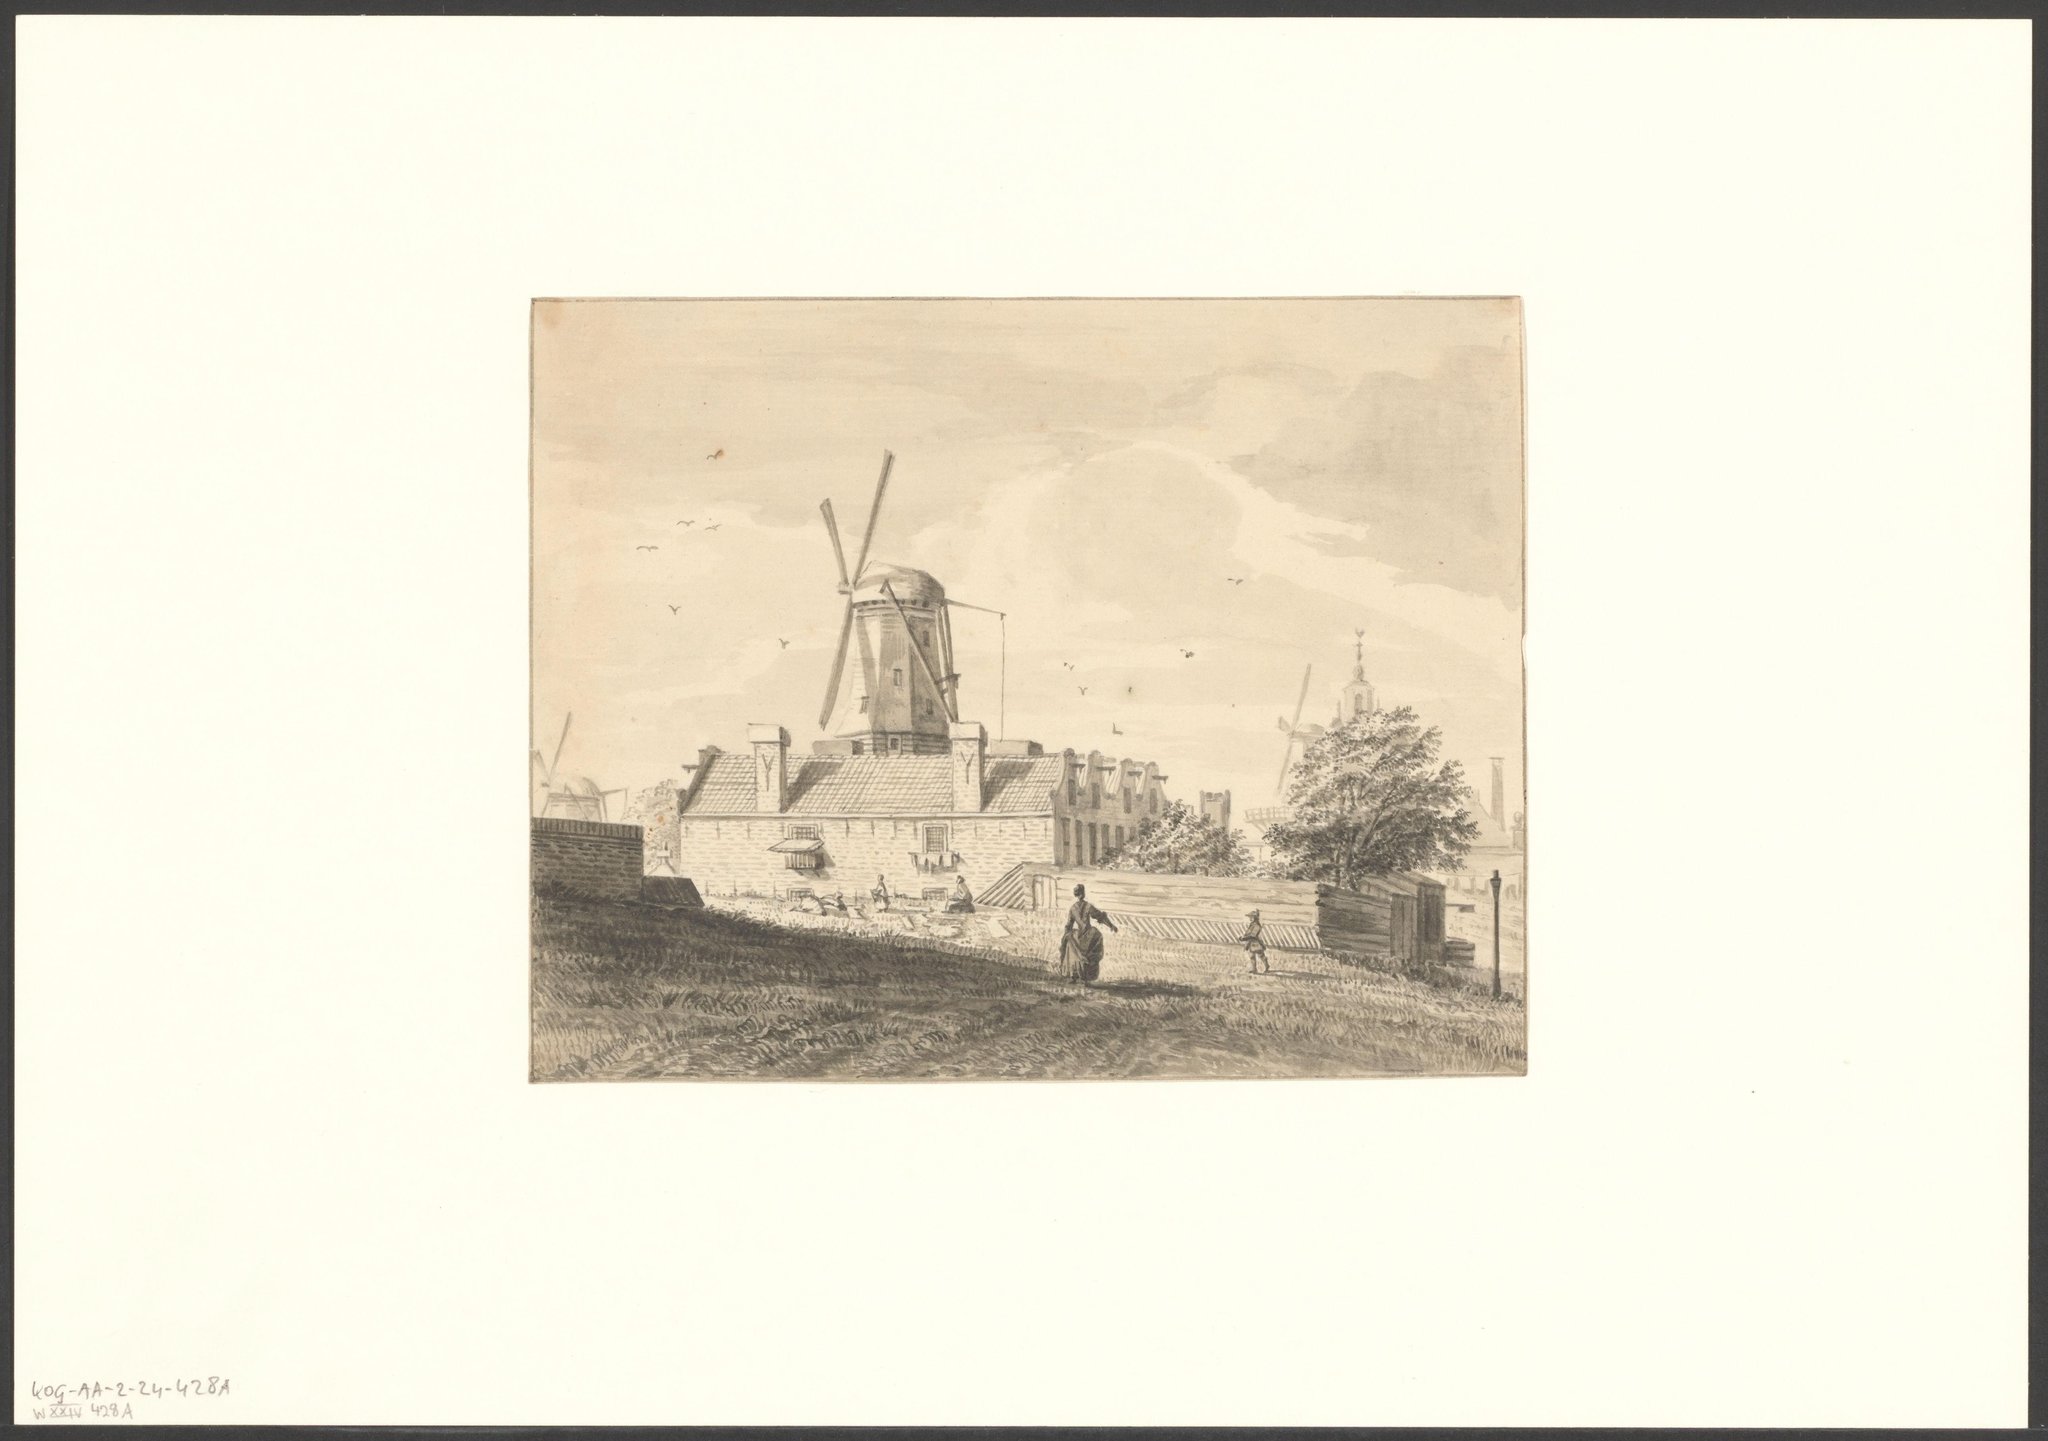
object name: drawing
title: Gezicht op bolwerk Sloterdijk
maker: bartholomeus barbiers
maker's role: draughtsman, painter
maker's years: 1740-1808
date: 1750-1808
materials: ink, paper, pencil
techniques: brush, pen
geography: amsterdam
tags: city-view in general; 'veduta', windmill in landscape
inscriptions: collector's mark: Lugt 1557, inscription: ‘de molen de Kraai tezien van de / Pa[...]lstraat naar de Haarl. Poort / Bolwerk Sloter dijk’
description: Tekening binnen de Atlas Van Eck ingedeeld op wijknummer 24.